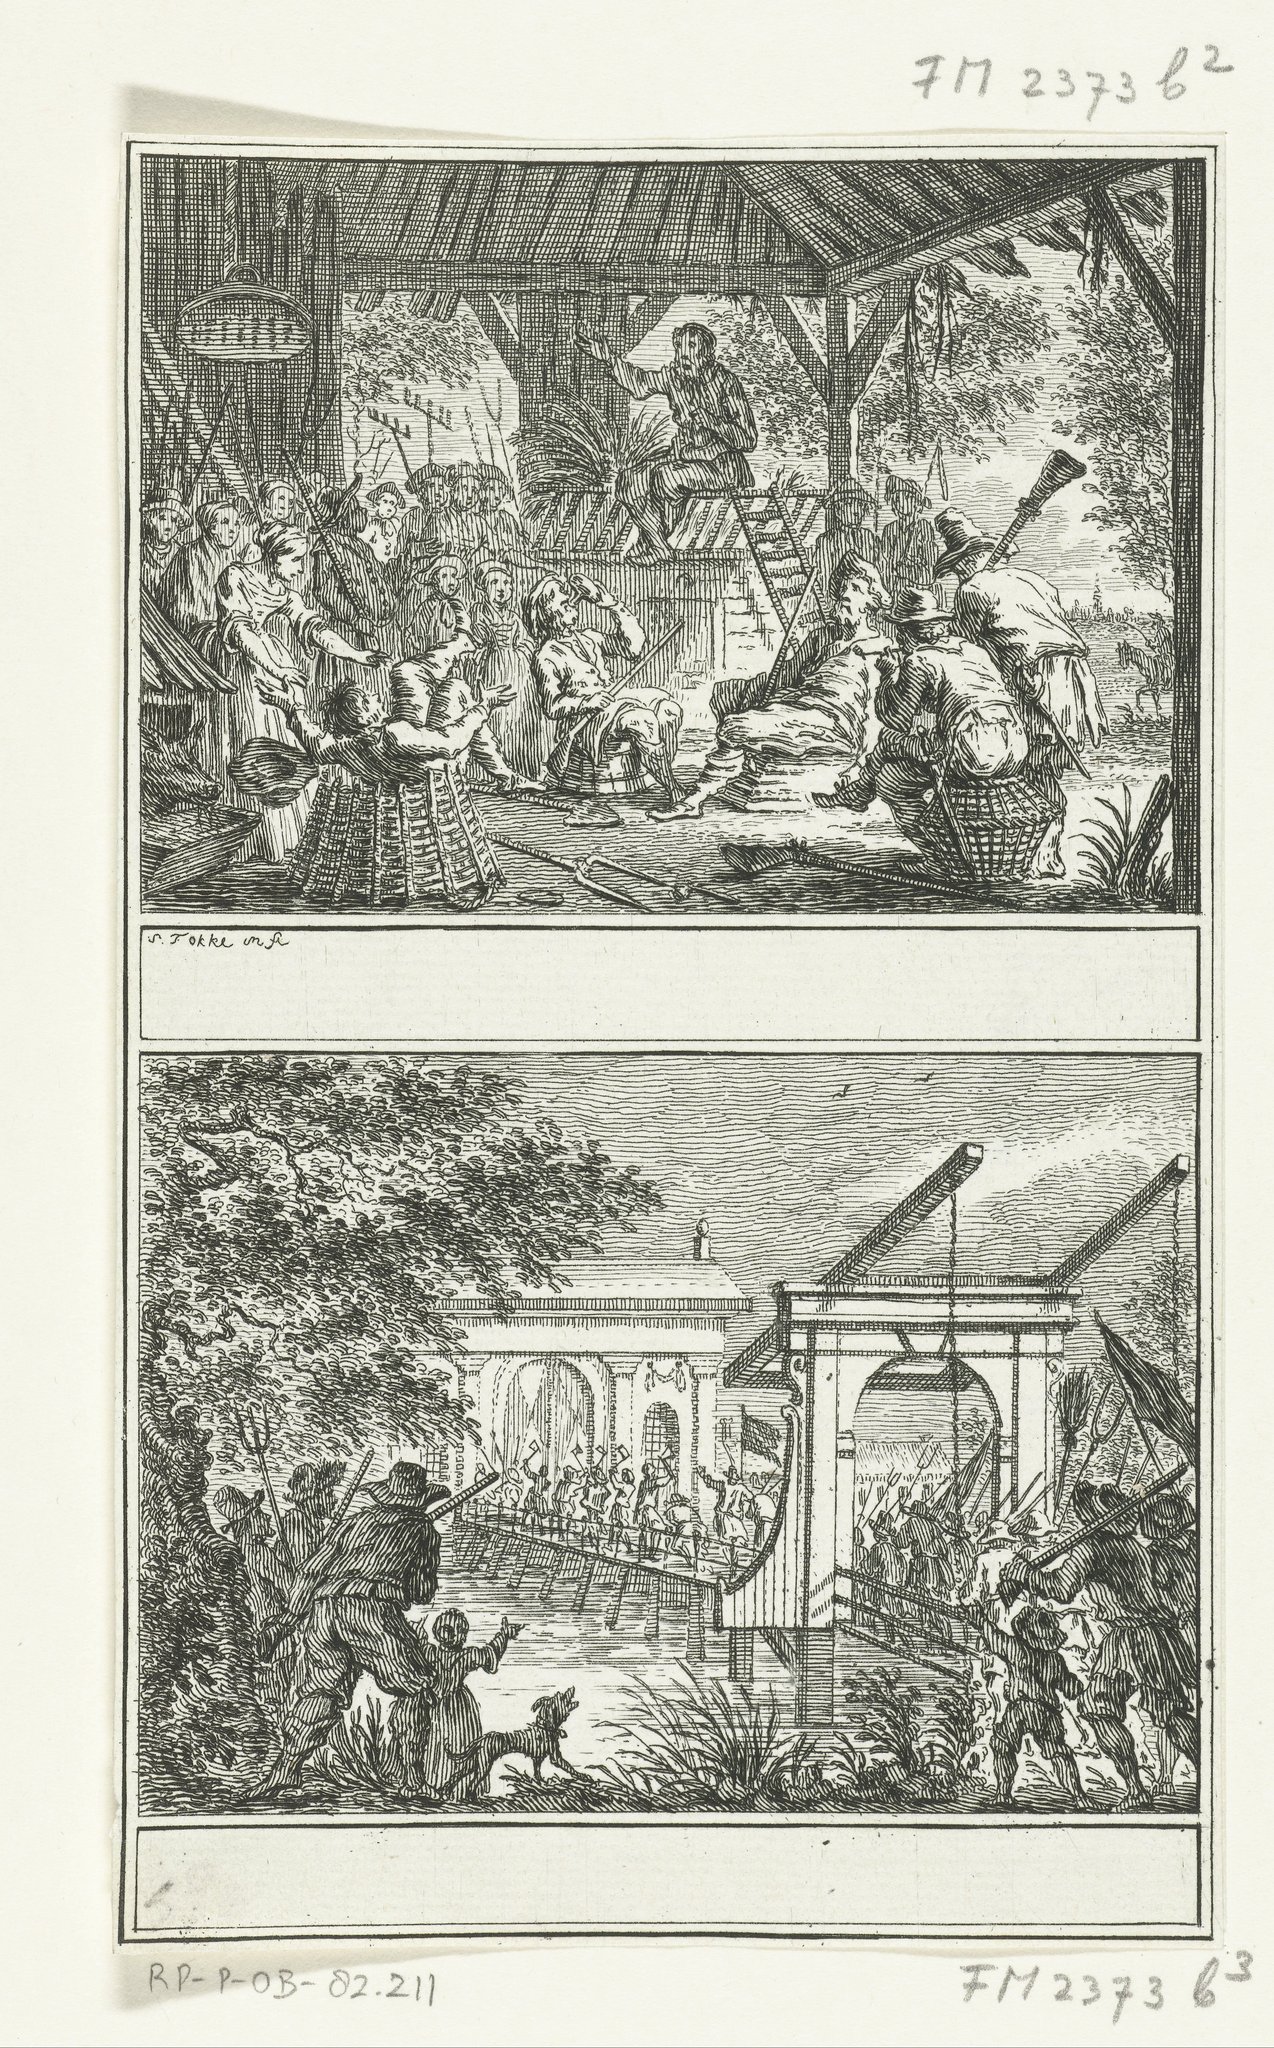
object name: print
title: Het preken van oproer onder de boeren / Bestorming van de Noordpoort te Middelburg, 1672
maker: simon fokke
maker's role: draughtsman, print maker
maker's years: 1712-1784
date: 1764-1766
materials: paper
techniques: etching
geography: northern netherlands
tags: middelburg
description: Blad met twee voorstellingen. Boven: het preken van oproer onder de boeren in een boerenschuur. Onder: de bestorming van de Noordpoort te Middelburg door de opstandige boeren, 1672. Illustraties nr. II en III bij een gedicht van Petrus Johannes Beronicius over de opstandige Zeeuwse boeren en het tumult te Middelburg rond burgemeester Filips van den Brande op 21 juli 1672.